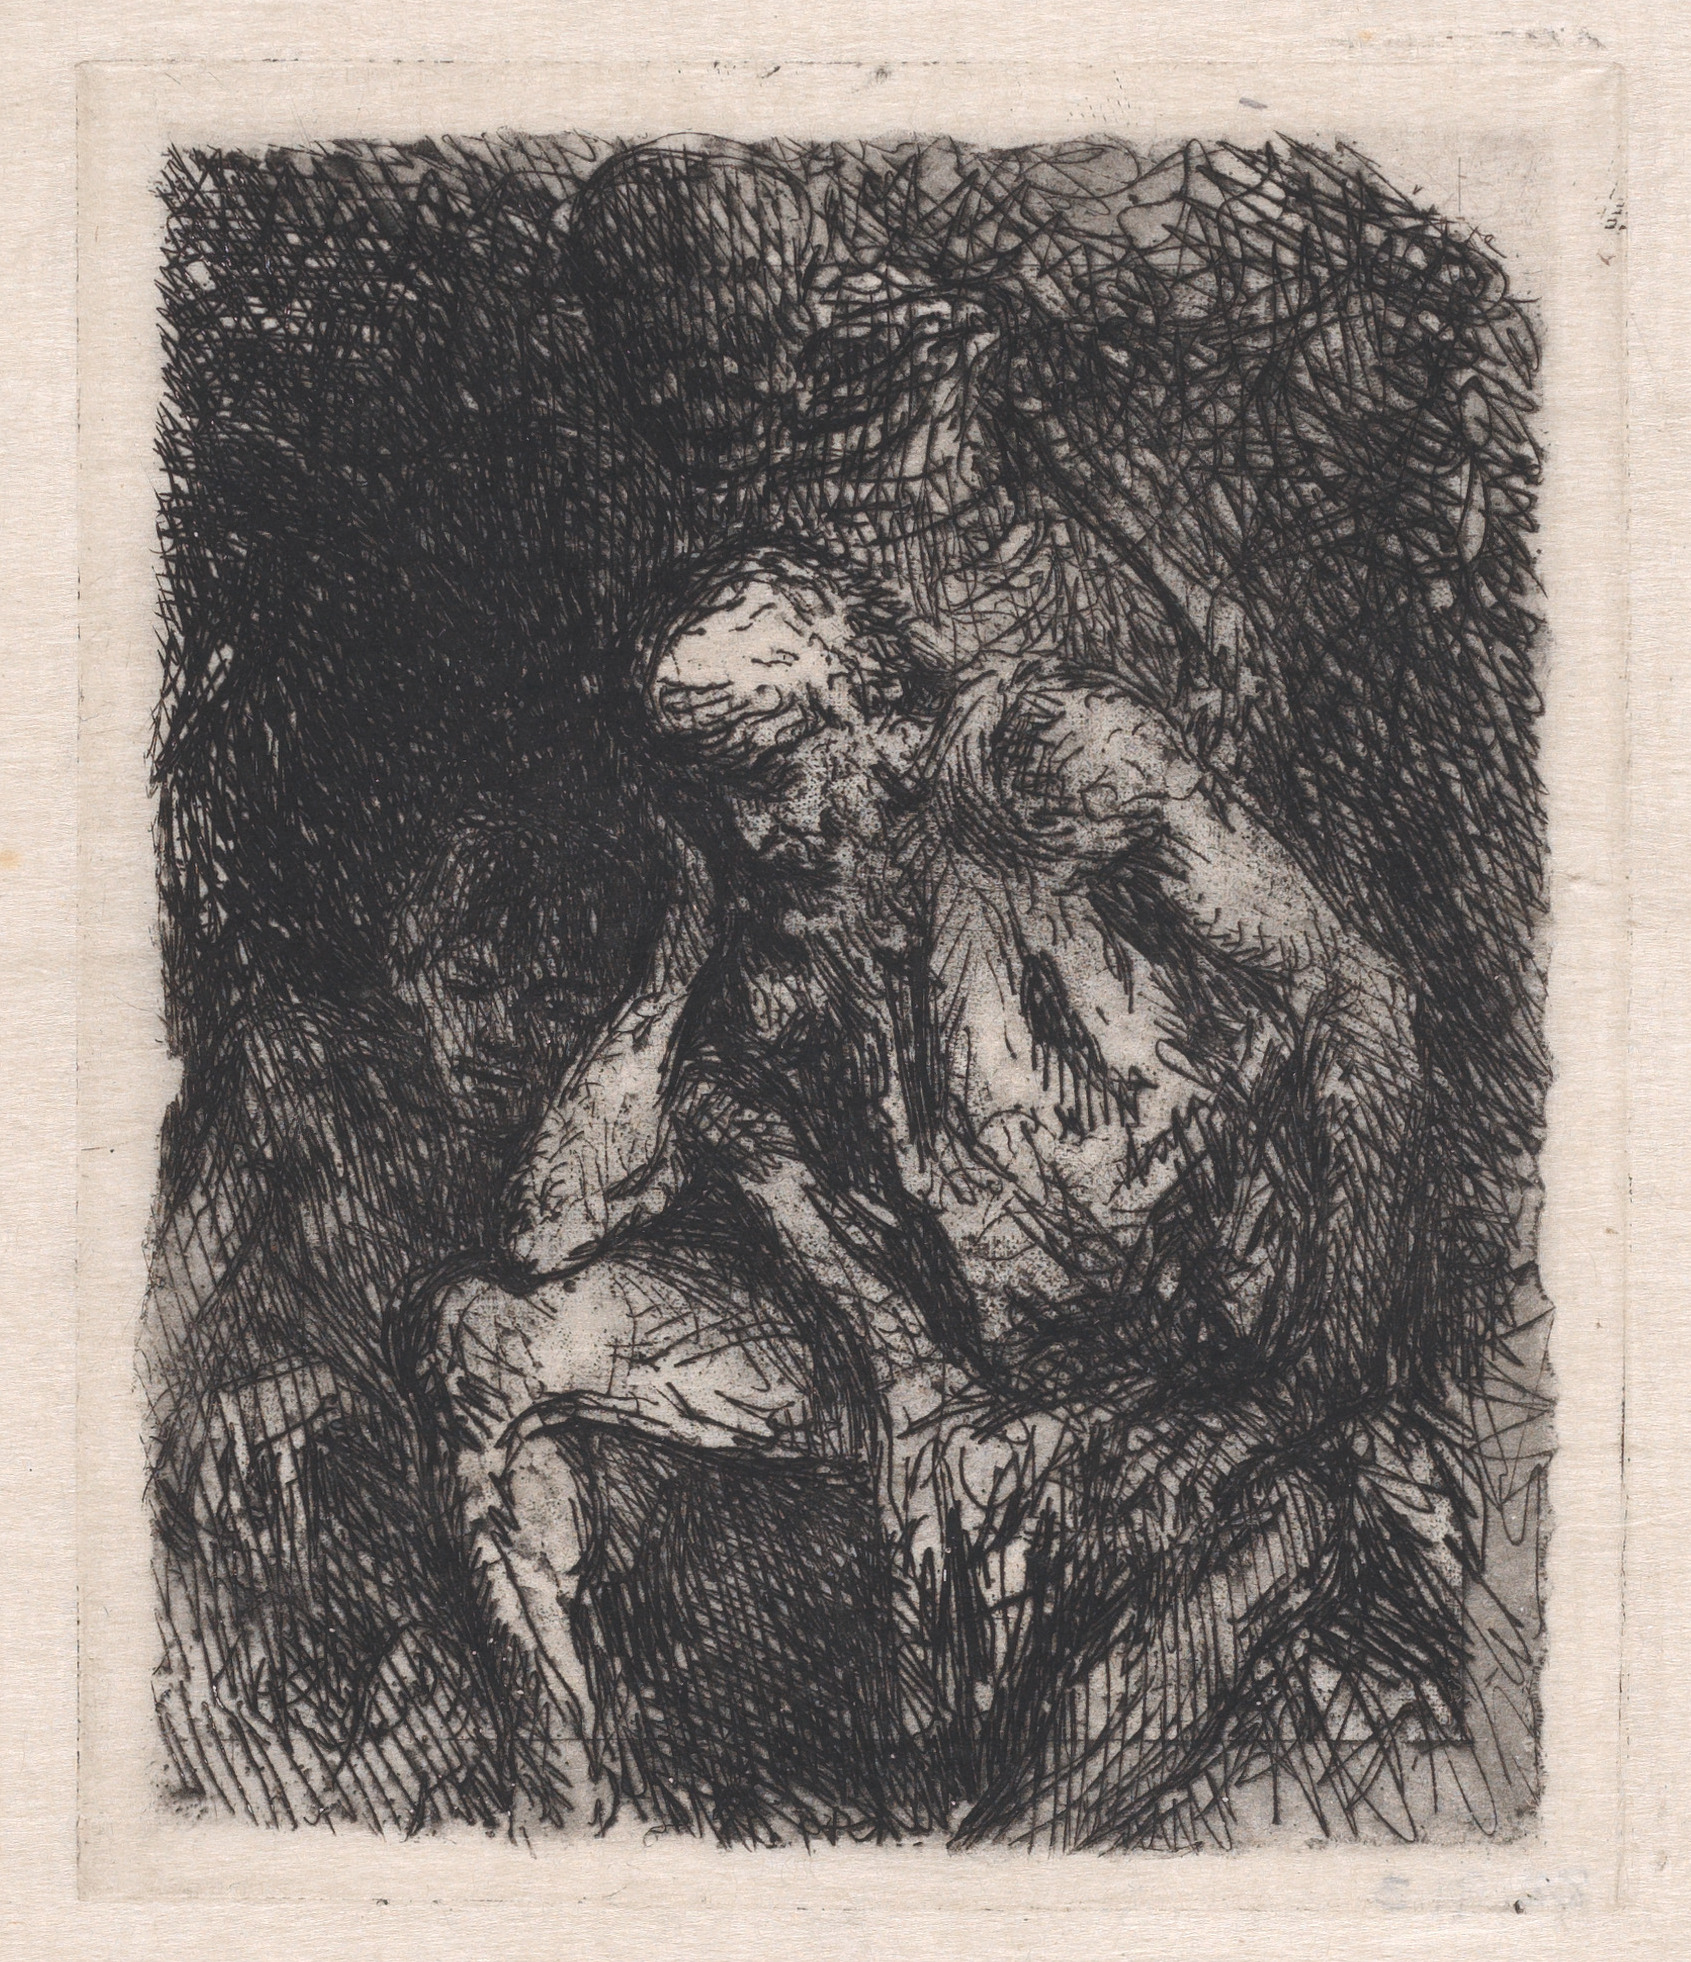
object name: print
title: Petites Barques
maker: charles émile jacque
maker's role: artist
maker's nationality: french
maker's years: 1813-1894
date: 1801-1900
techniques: etching